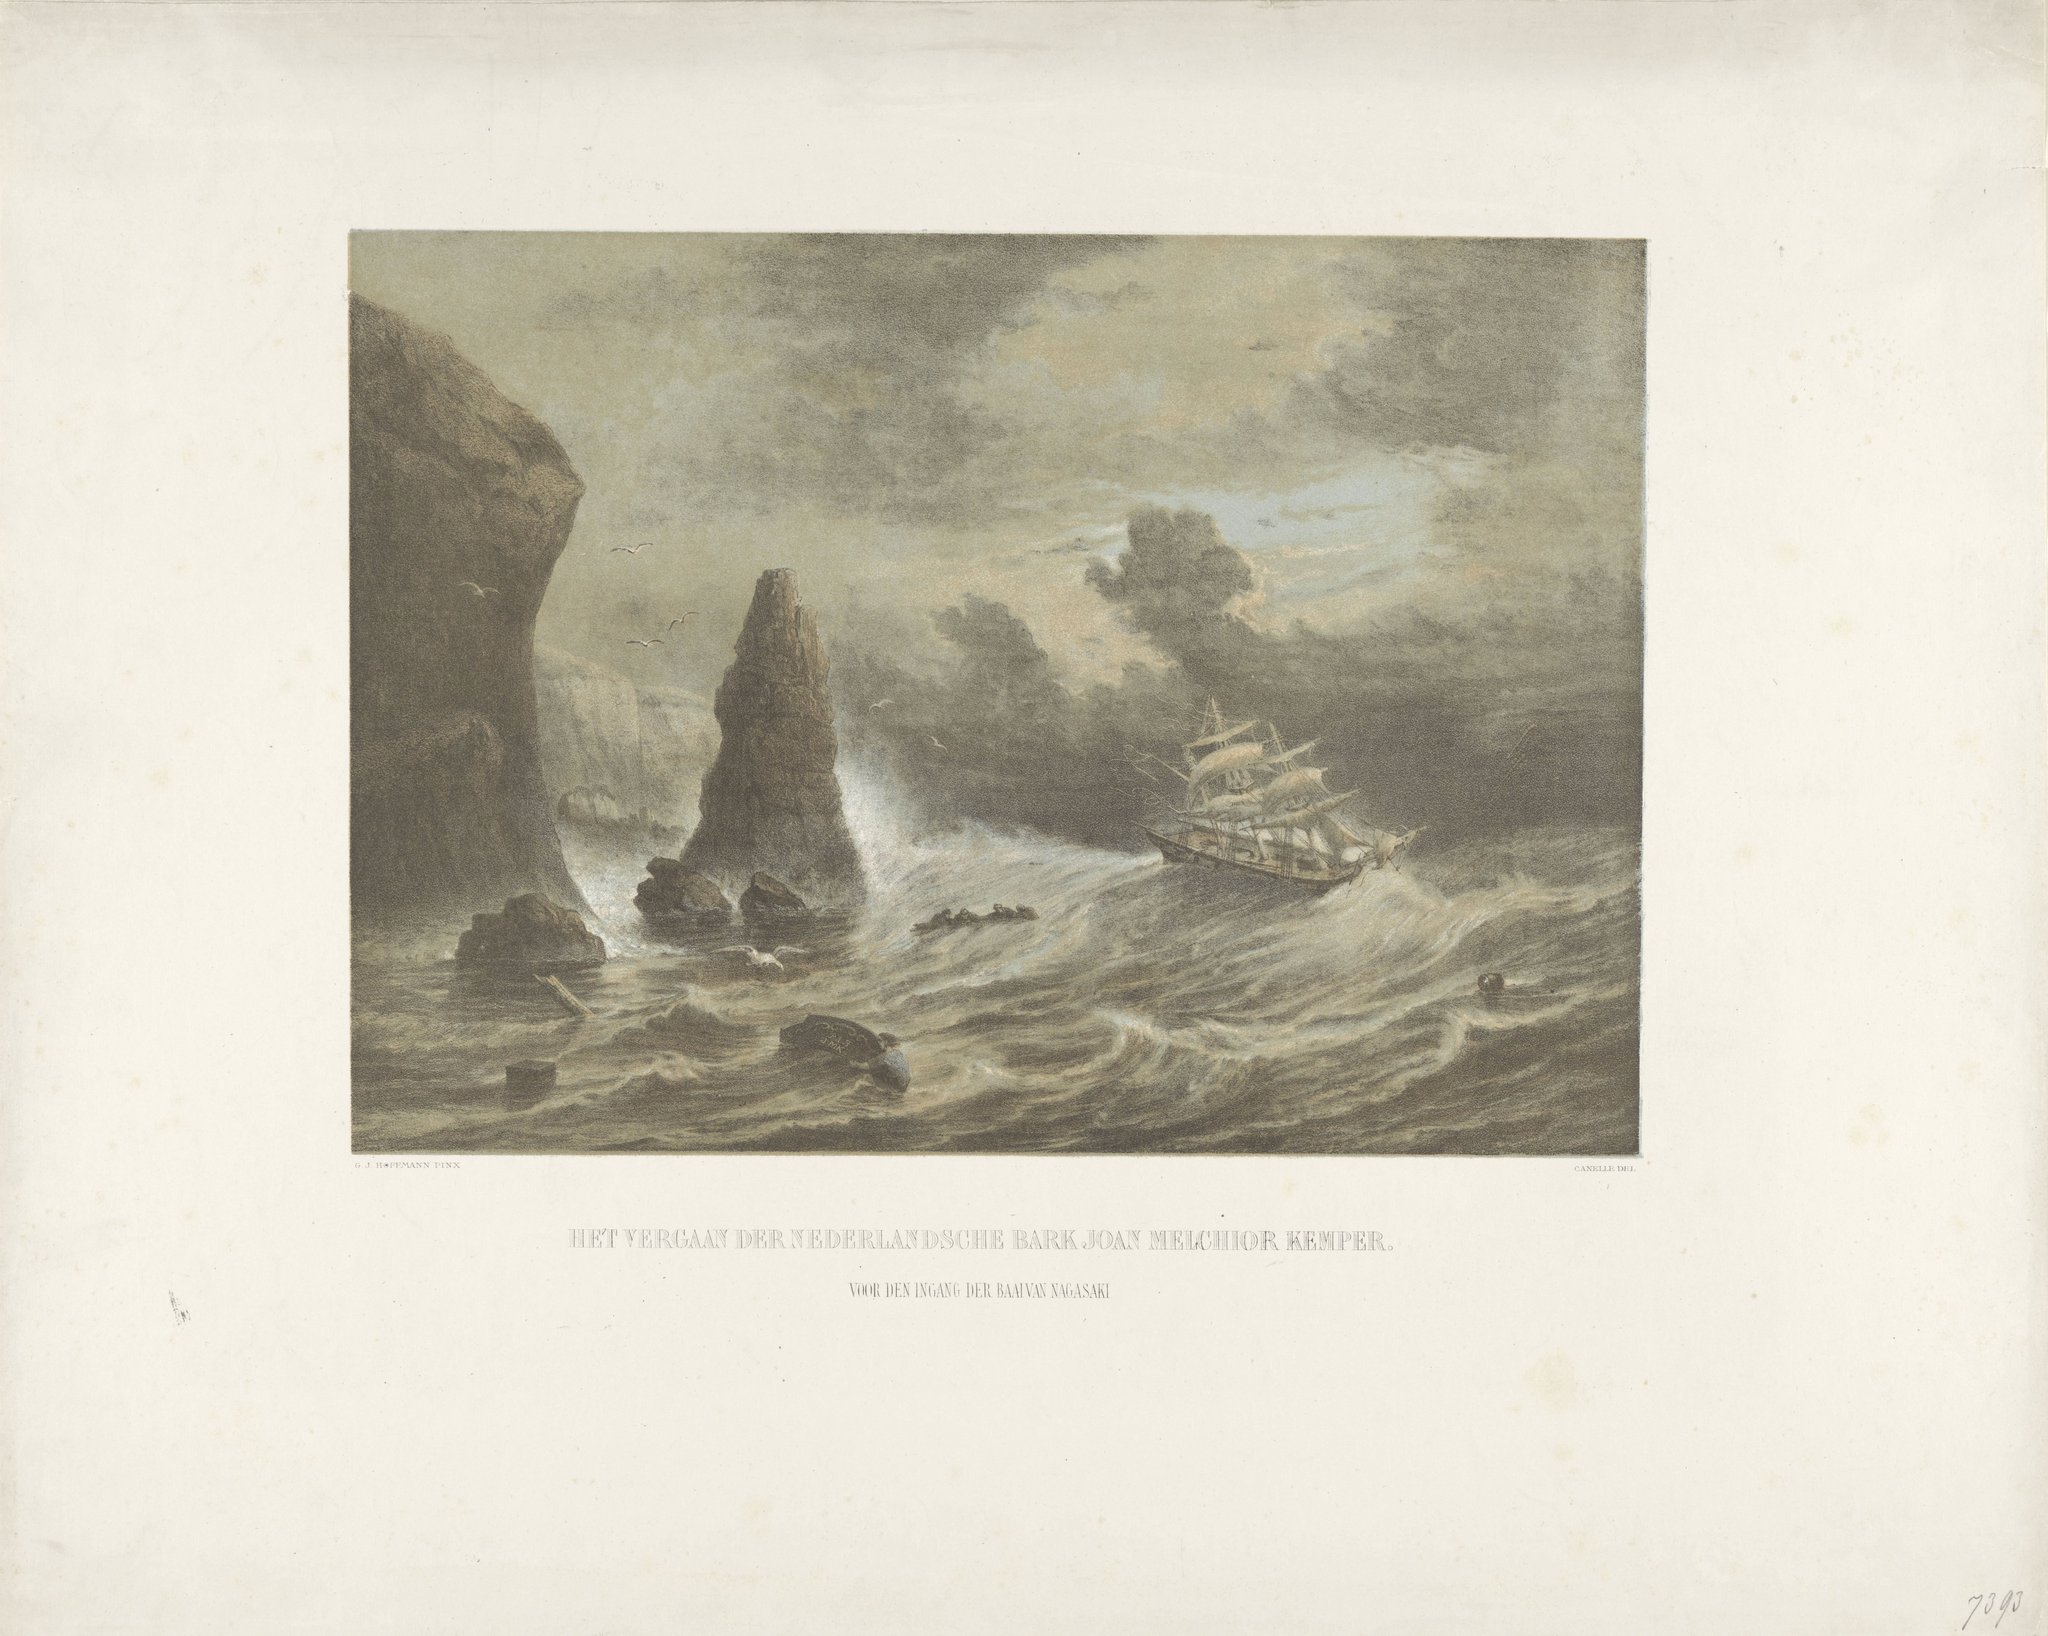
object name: print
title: Shipwreck of the Joan Melchior Kemper at Nagasaki Bay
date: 1865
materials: paper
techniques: lithograph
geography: netherlands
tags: drowning, shipwrecked person, shipwreck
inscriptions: collector's mark: Lugt 2228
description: On 10 September 1865, the Dutch merchant ship Joan Melchior Kemper foundered at the mouth of Nagasaki Bay. In the foreground of this print is the sole survivor: Wietze Hoogenterp. He convalesced in the home of Albert Bauduin. This lithograph is an artist’s imagined rendering of the disaster. As it could not be photographed, this was the next best thing.